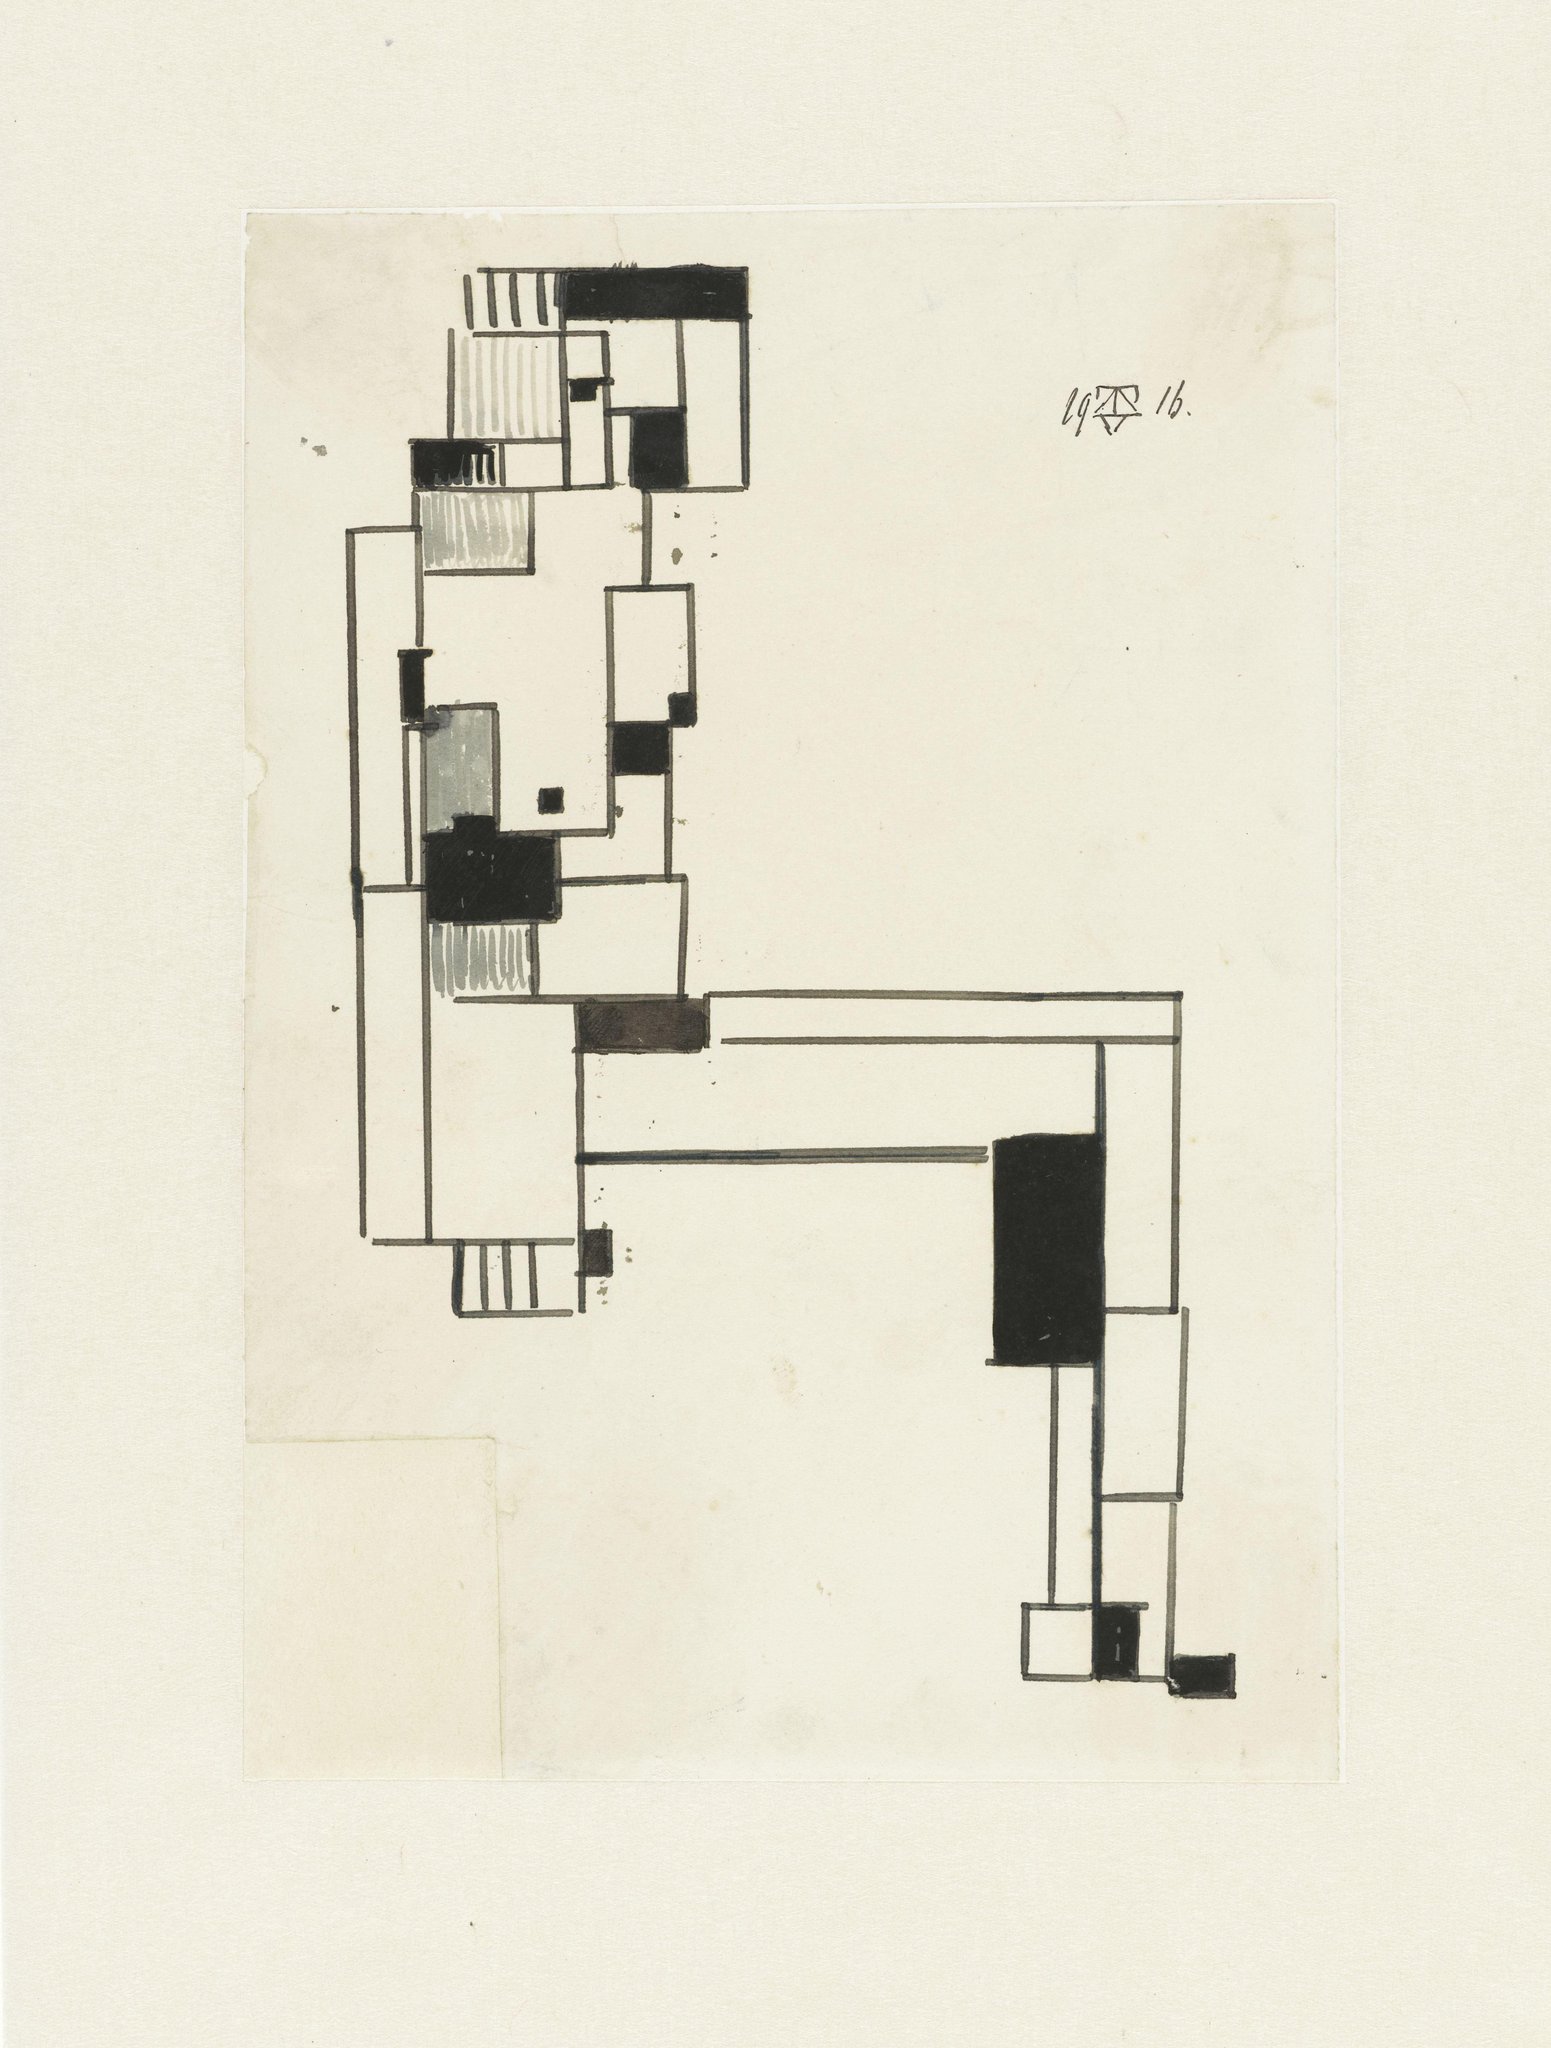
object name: drawing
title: Seated Female Nude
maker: theo van doesburg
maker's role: draughtsman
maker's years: 1883-1931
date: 1916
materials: ink, paper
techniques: brush, pen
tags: sitting figure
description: Van Doesburg described in a letter that he had attempted ‘to introduce rhythmical movement in the torso and create a flat sense of space through lines and planes’ in this work. The drawing was the result of ‘further abstraction,’ by which he meant reducing the subject-matter to elementary forms. As for his colleague Mondrian, for Van Doesburg this was the path to a new, universal art.